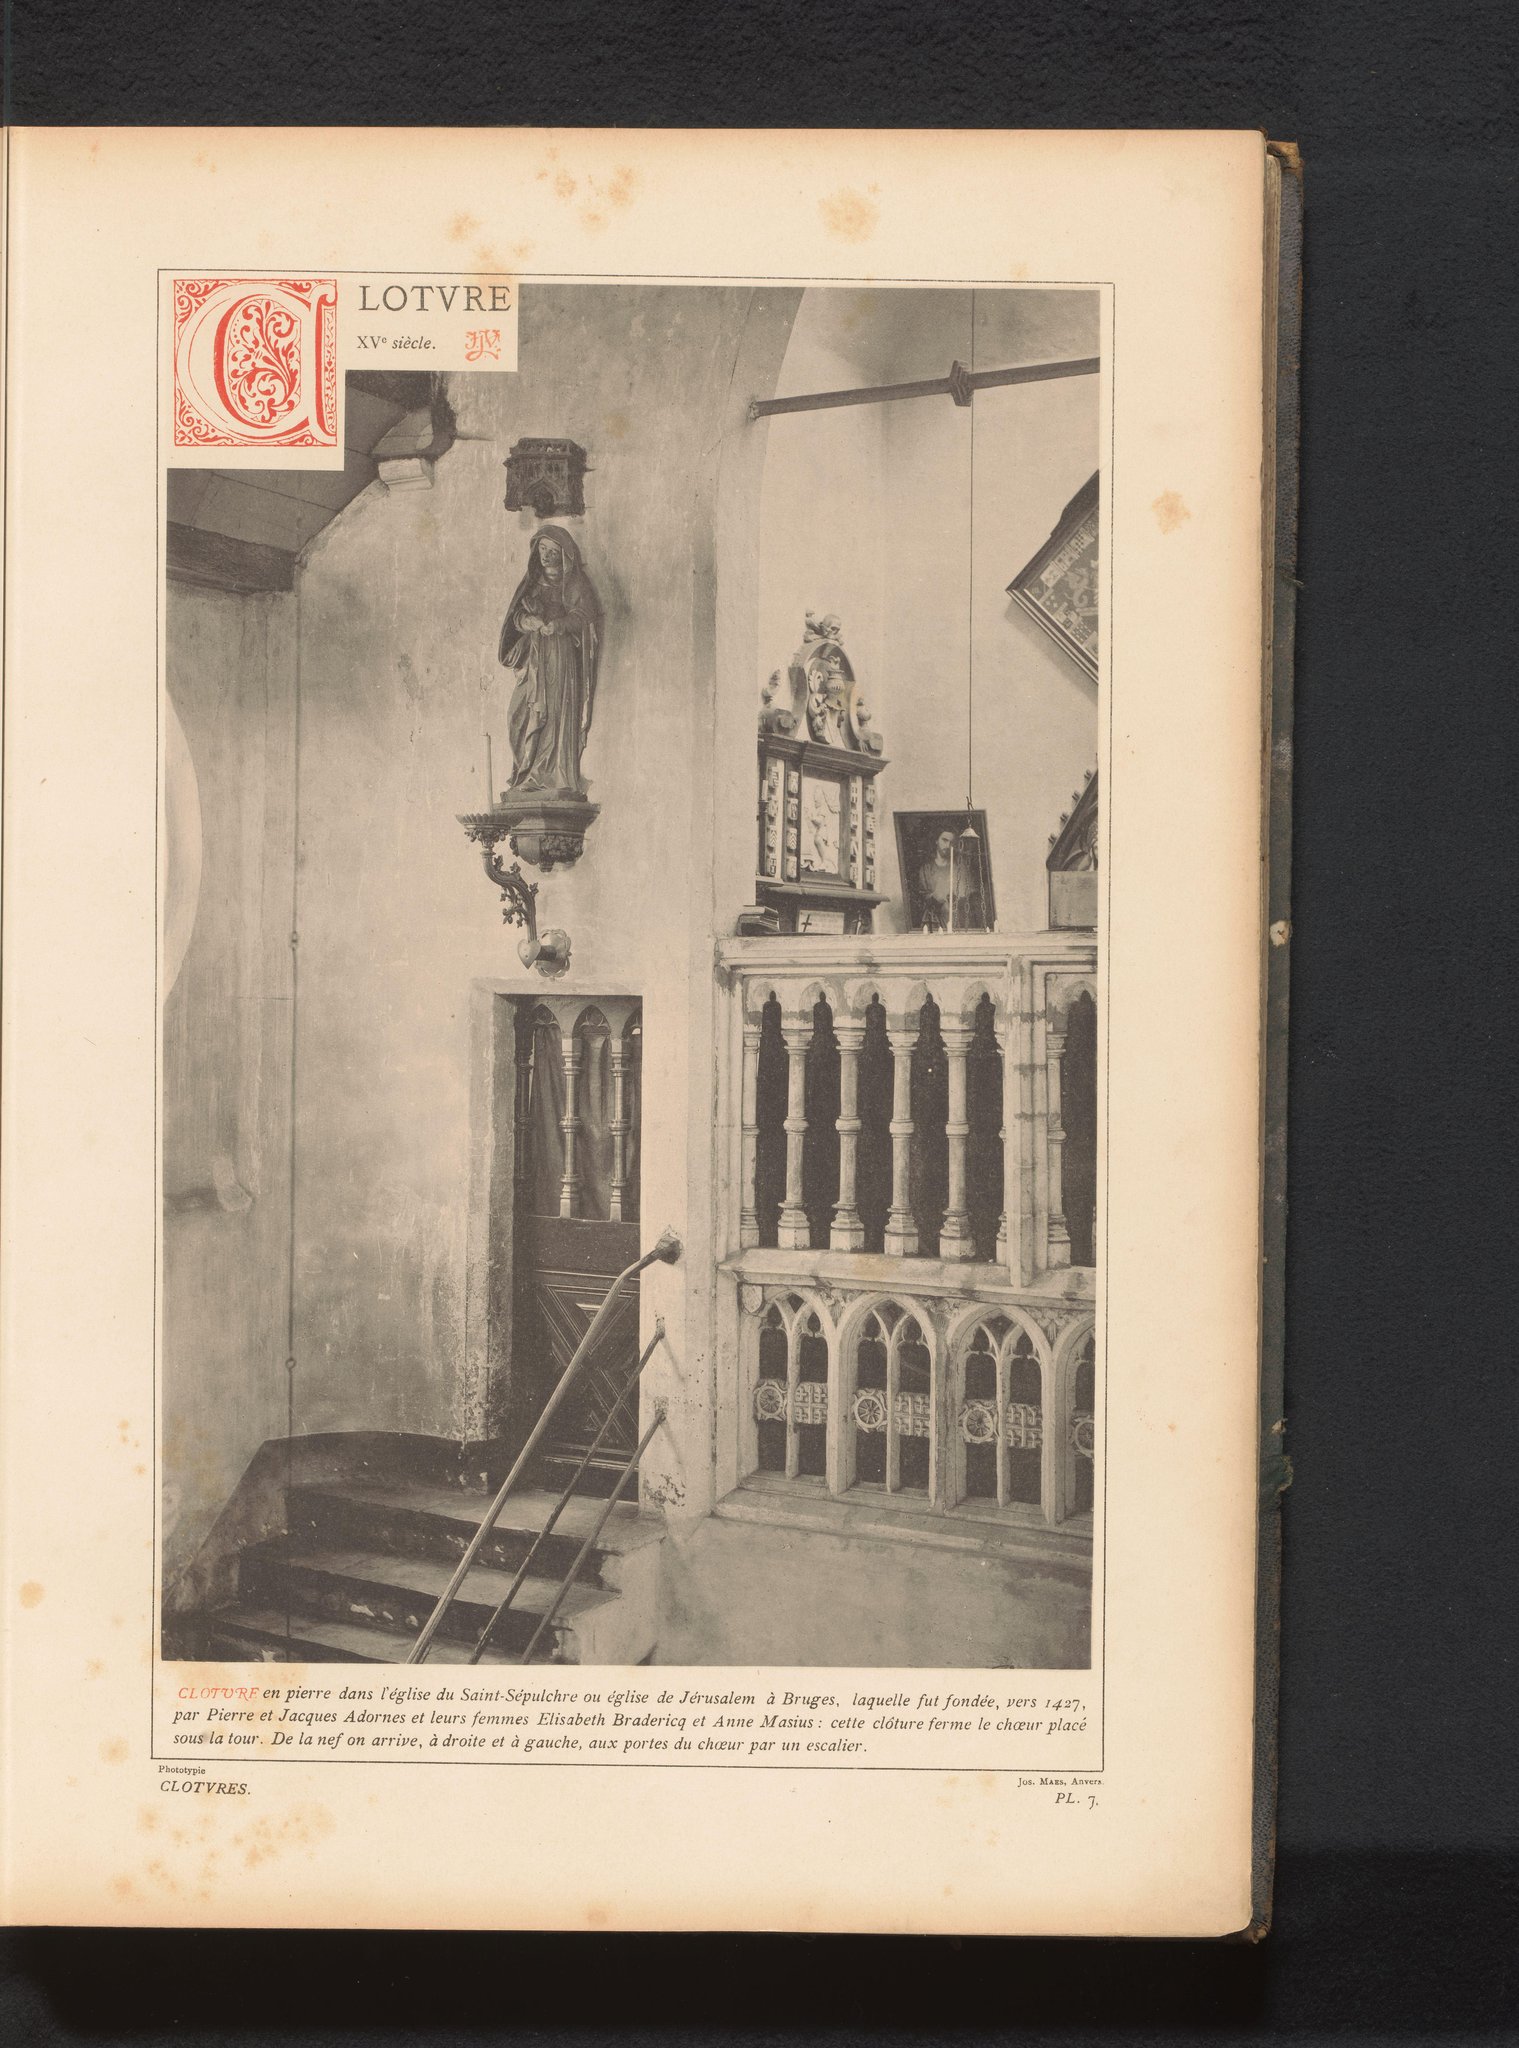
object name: page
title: Koorhek in de Jeruzalemkerk in Brugge, België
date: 1882-1887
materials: paper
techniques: photograph, photolithography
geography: jeruzalemkerk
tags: parts of church interior: choir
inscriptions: inscription: ‘CLOTURES. - PL. 7.’, inscription: ‘CLOTURE en pierre (...)’, monogram: ‘JJvY’